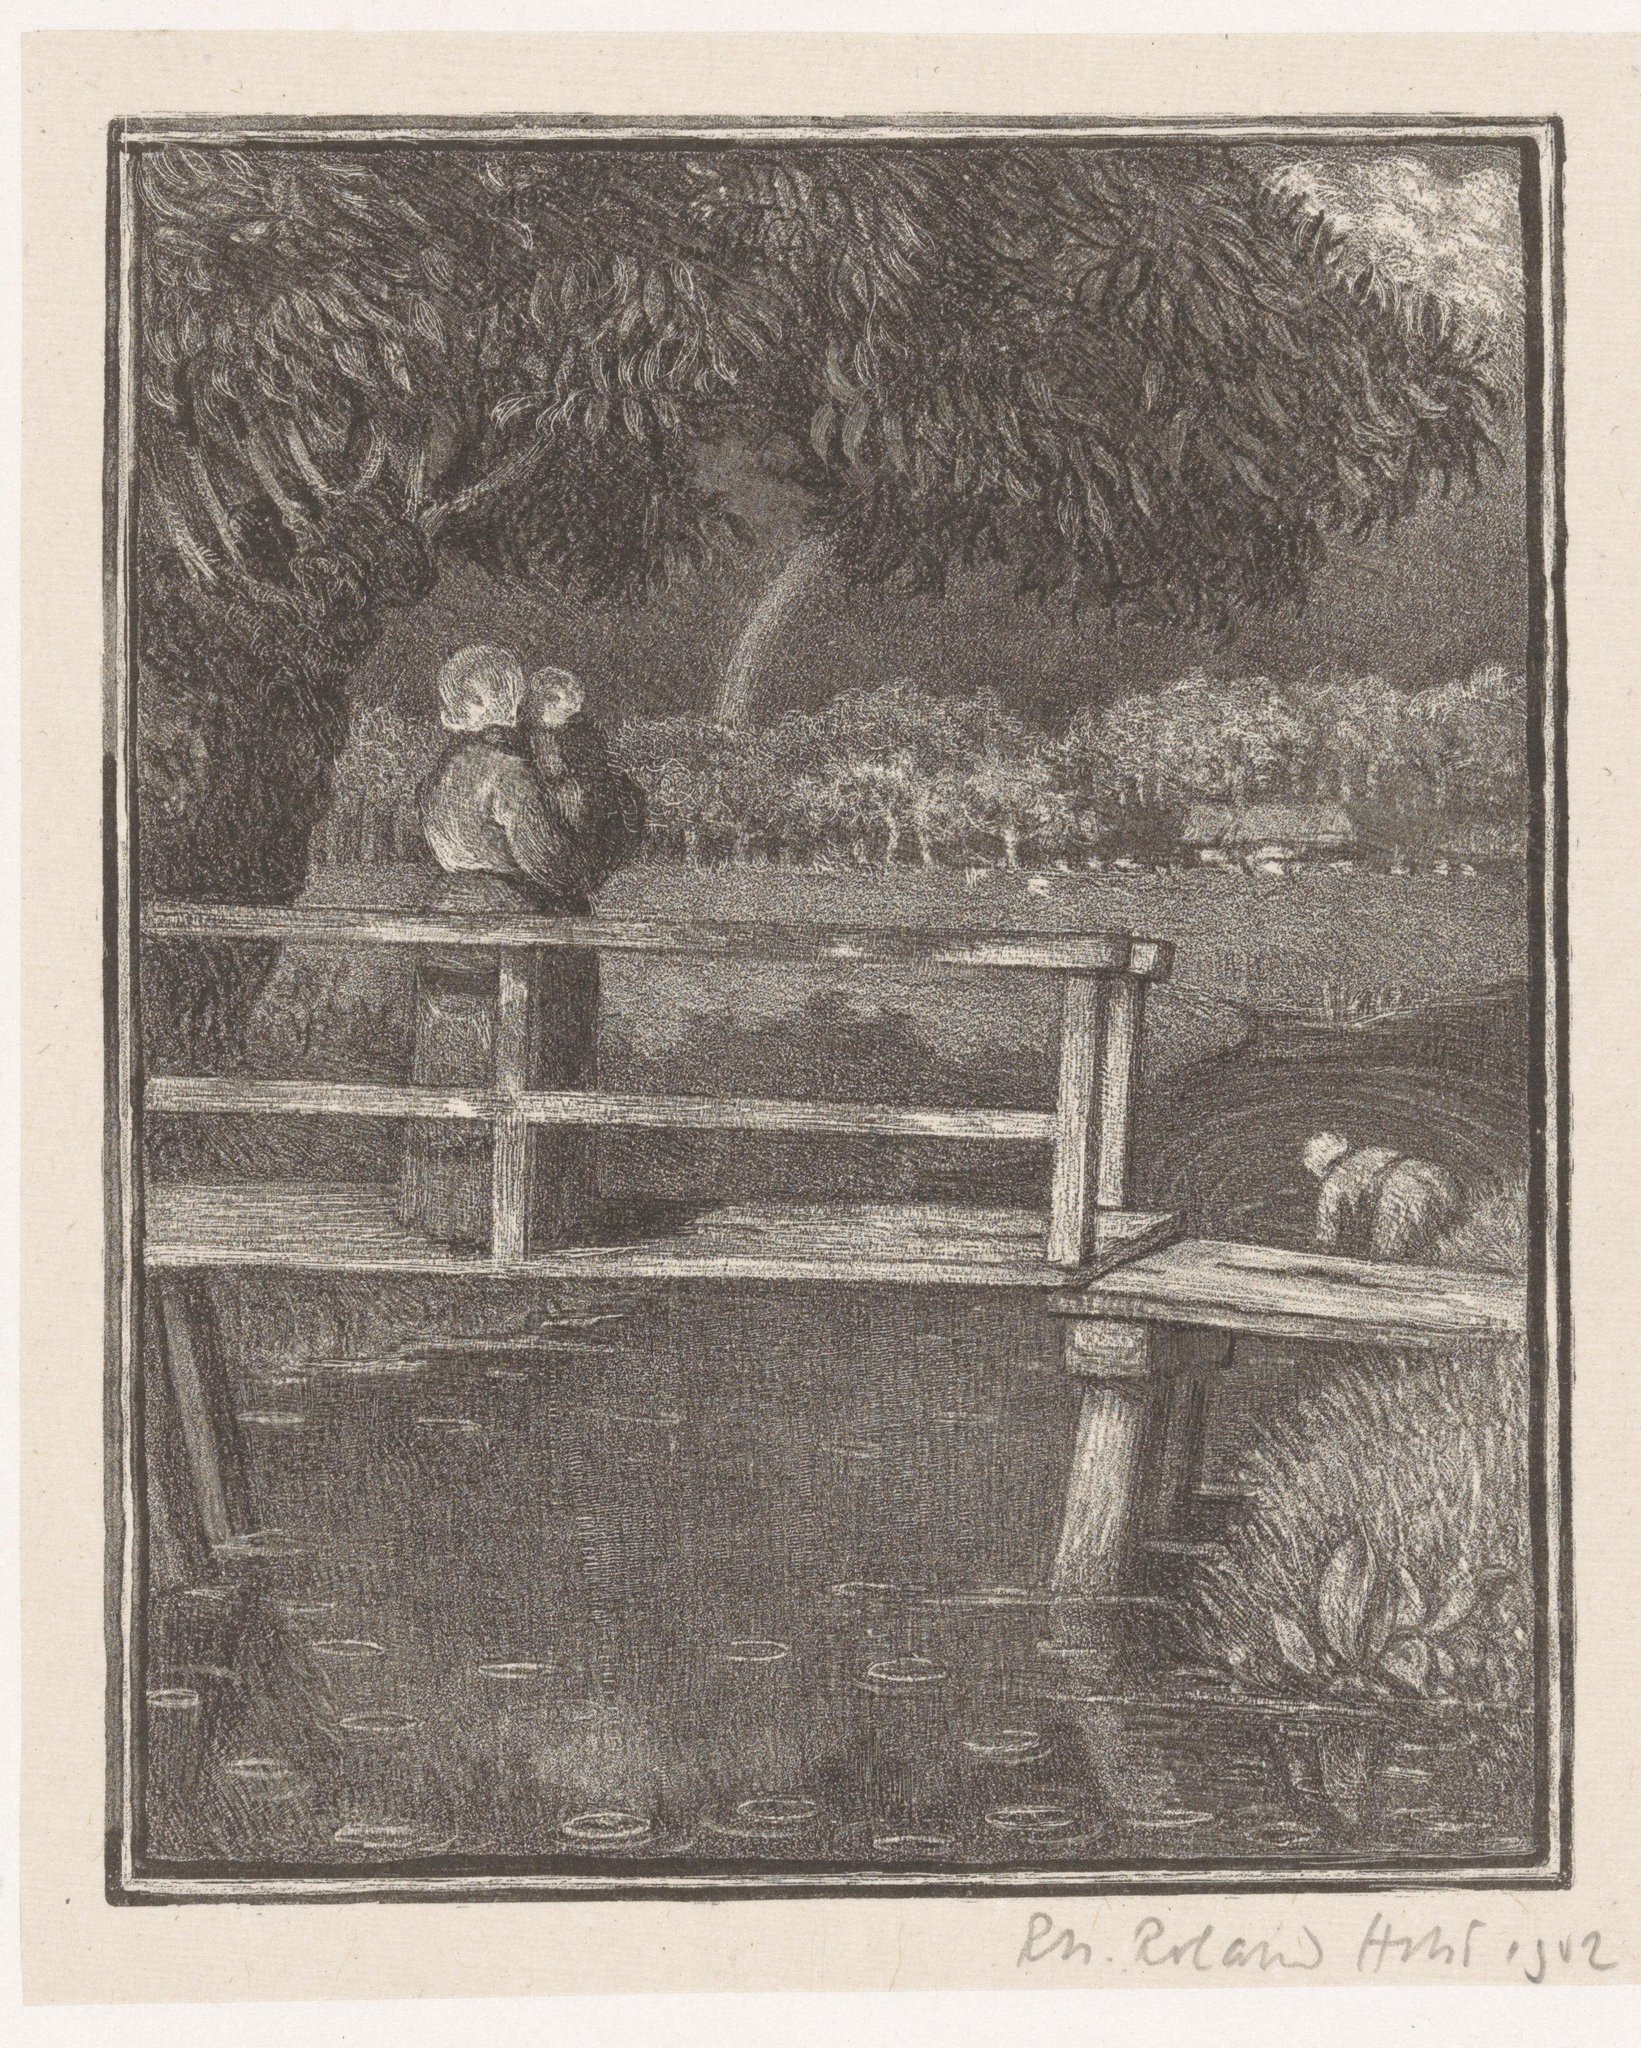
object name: print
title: Onweer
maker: richard nicolaüs roland holst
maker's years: 1868-1938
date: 1912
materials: paper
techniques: lithograph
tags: carrying a person, rain, bridge, mother and child(ren), woman and child(ren) (family group)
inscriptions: collector's mark: Lugt 2228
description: Op de voorgrond bevinden er zich kringen in het water, mogelijk door neerslag. Op de achtergrond een knielende figuur in het water. De lucht is betrokken.